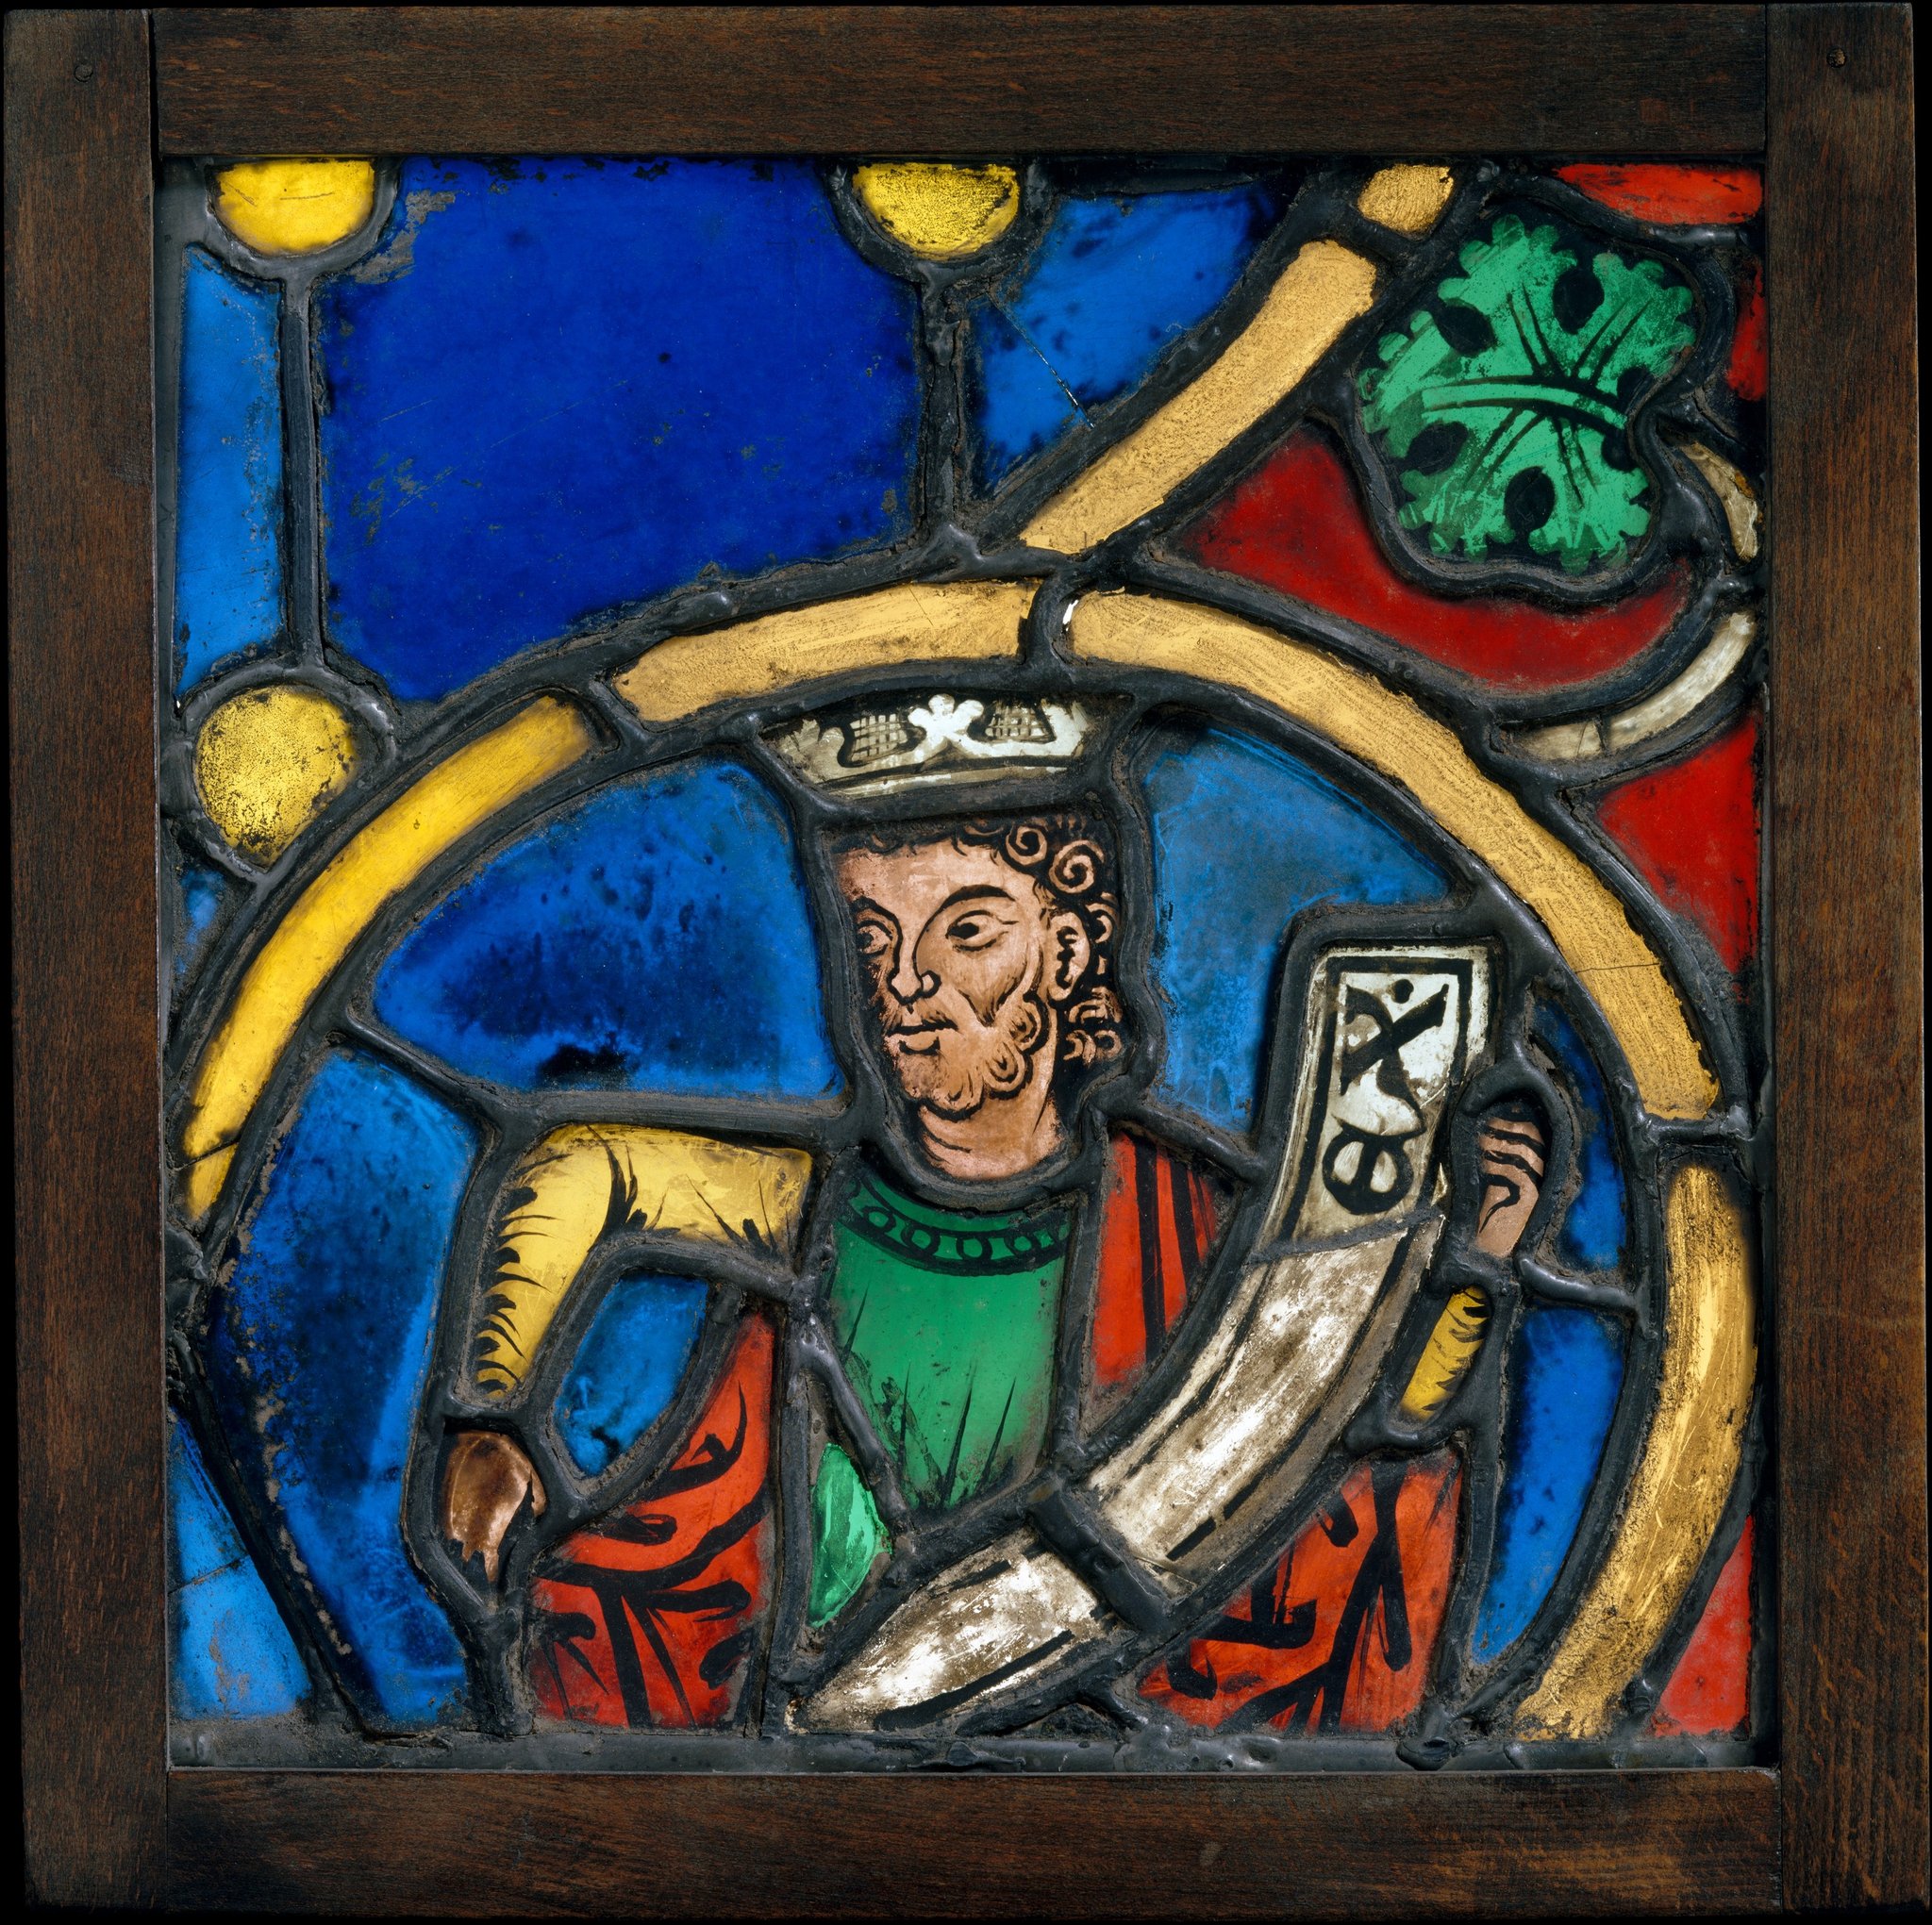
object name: panel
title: Prophet King from a Tree of Jesse Window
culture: german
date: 1260-1270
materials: glass, metal, paint, pigment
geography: germany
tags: kings,men